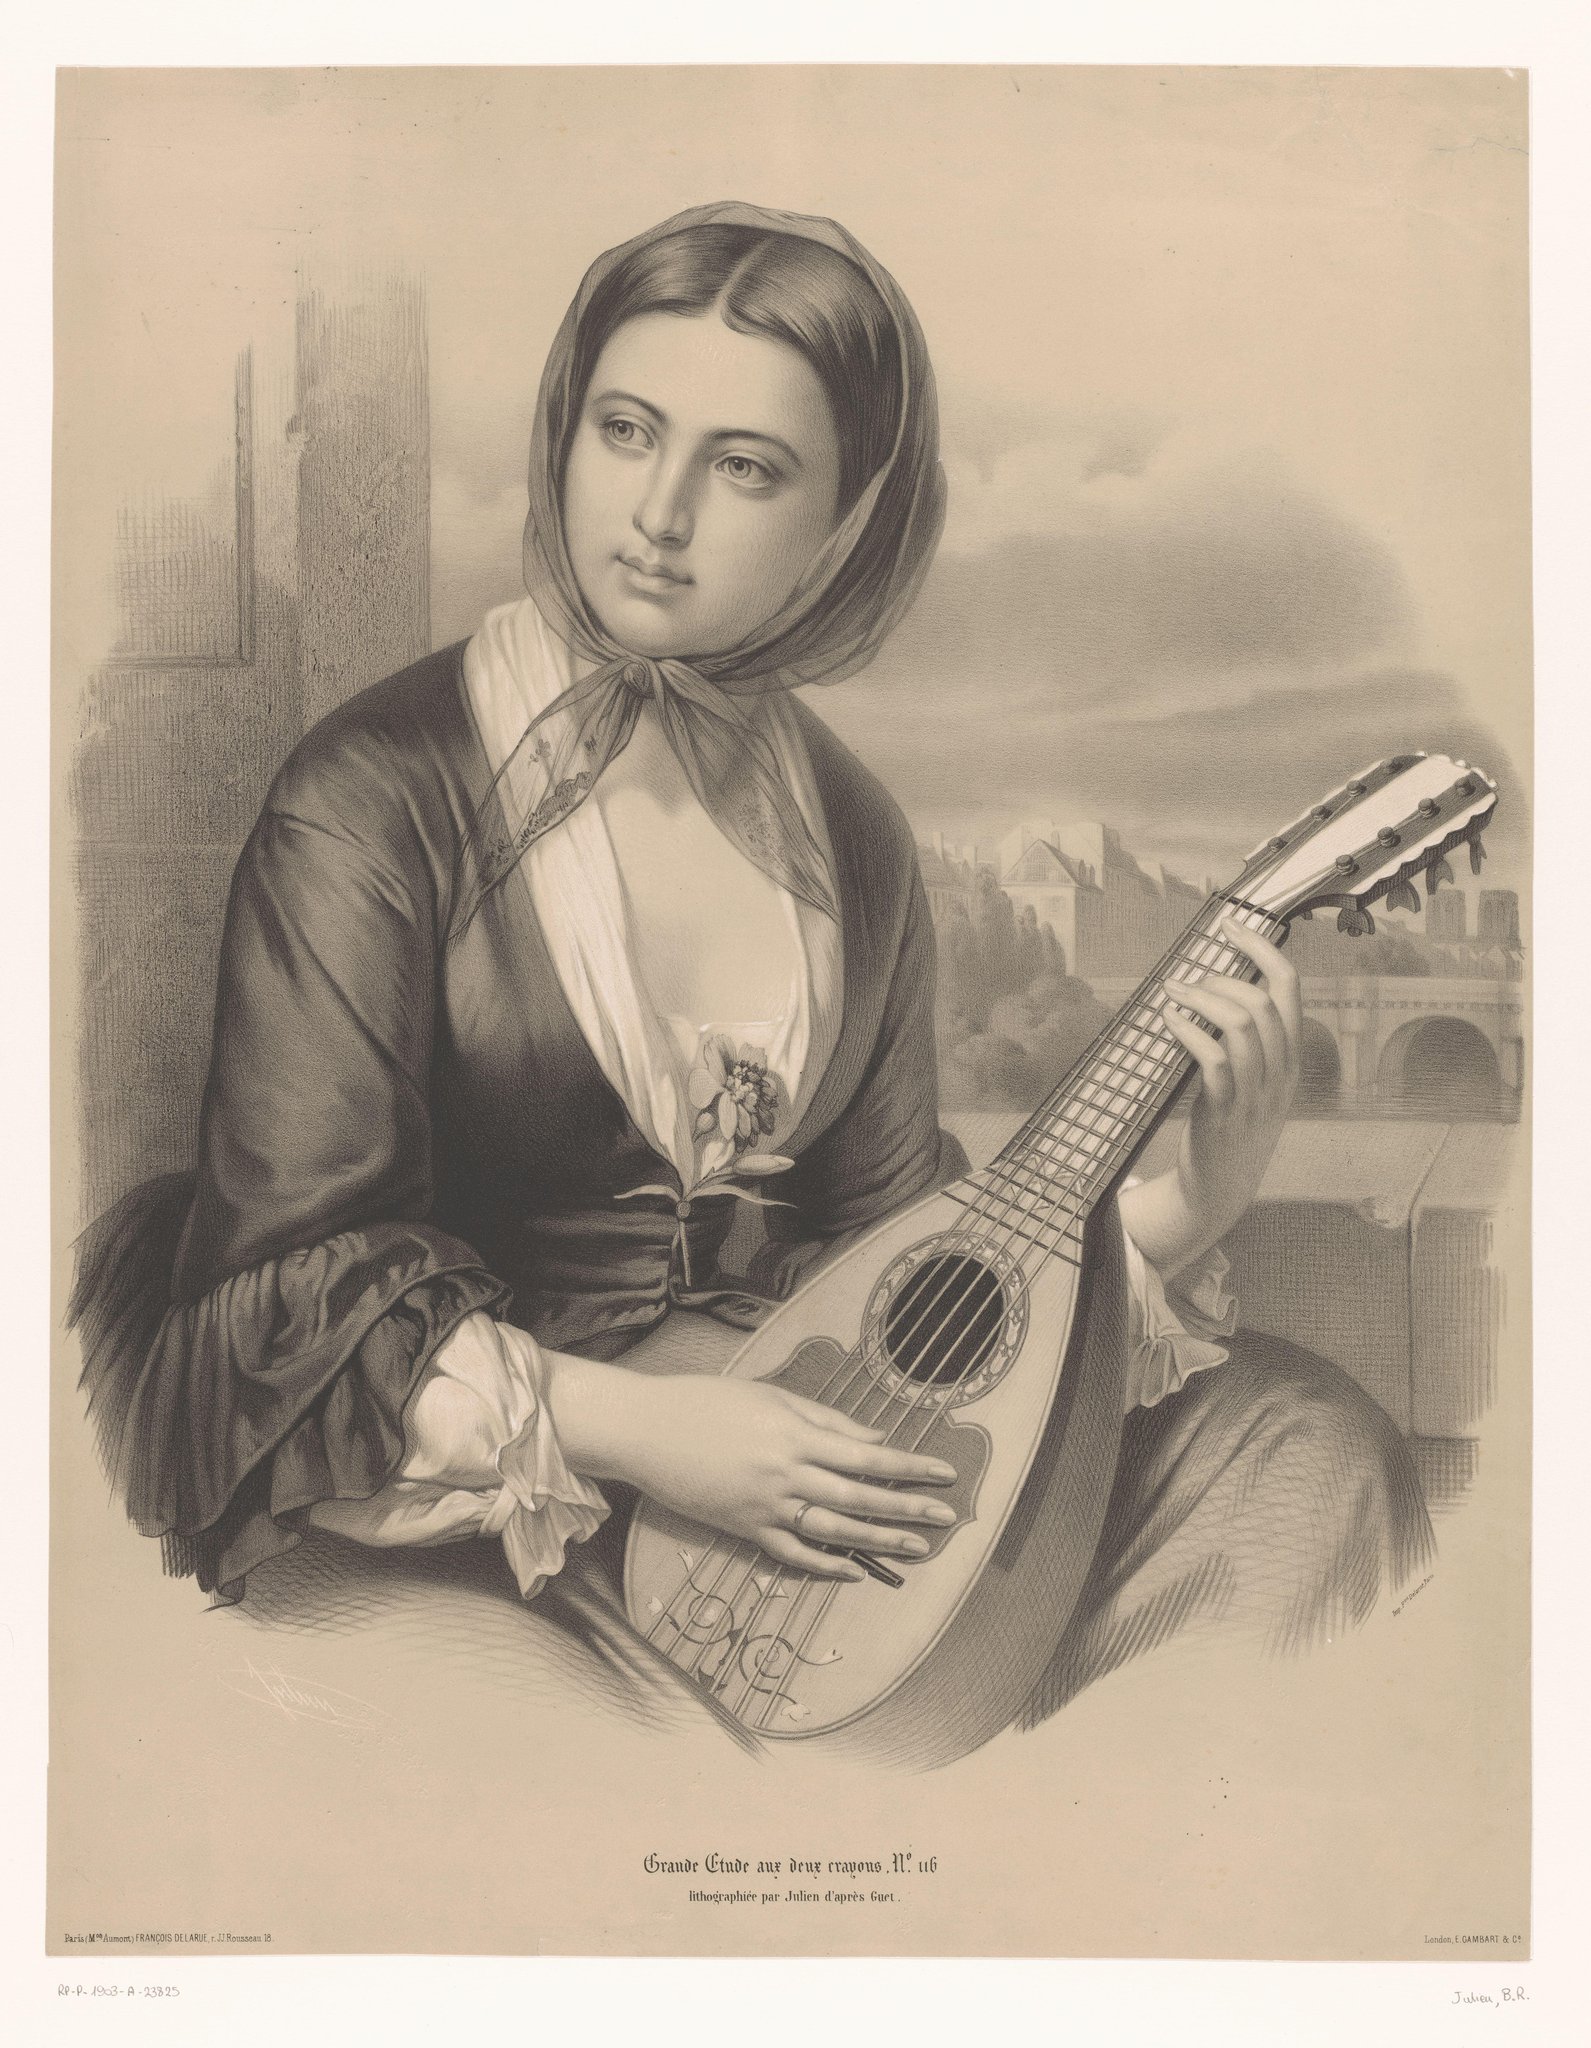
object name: print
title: Vrouw bespeelt een mandoline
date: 1851-1870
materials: paper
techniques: tone lithography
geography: paris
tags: one person playing an instrument, cithern, mandolin, guitar, balalaika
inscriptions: collector's mark: Lugt 2228